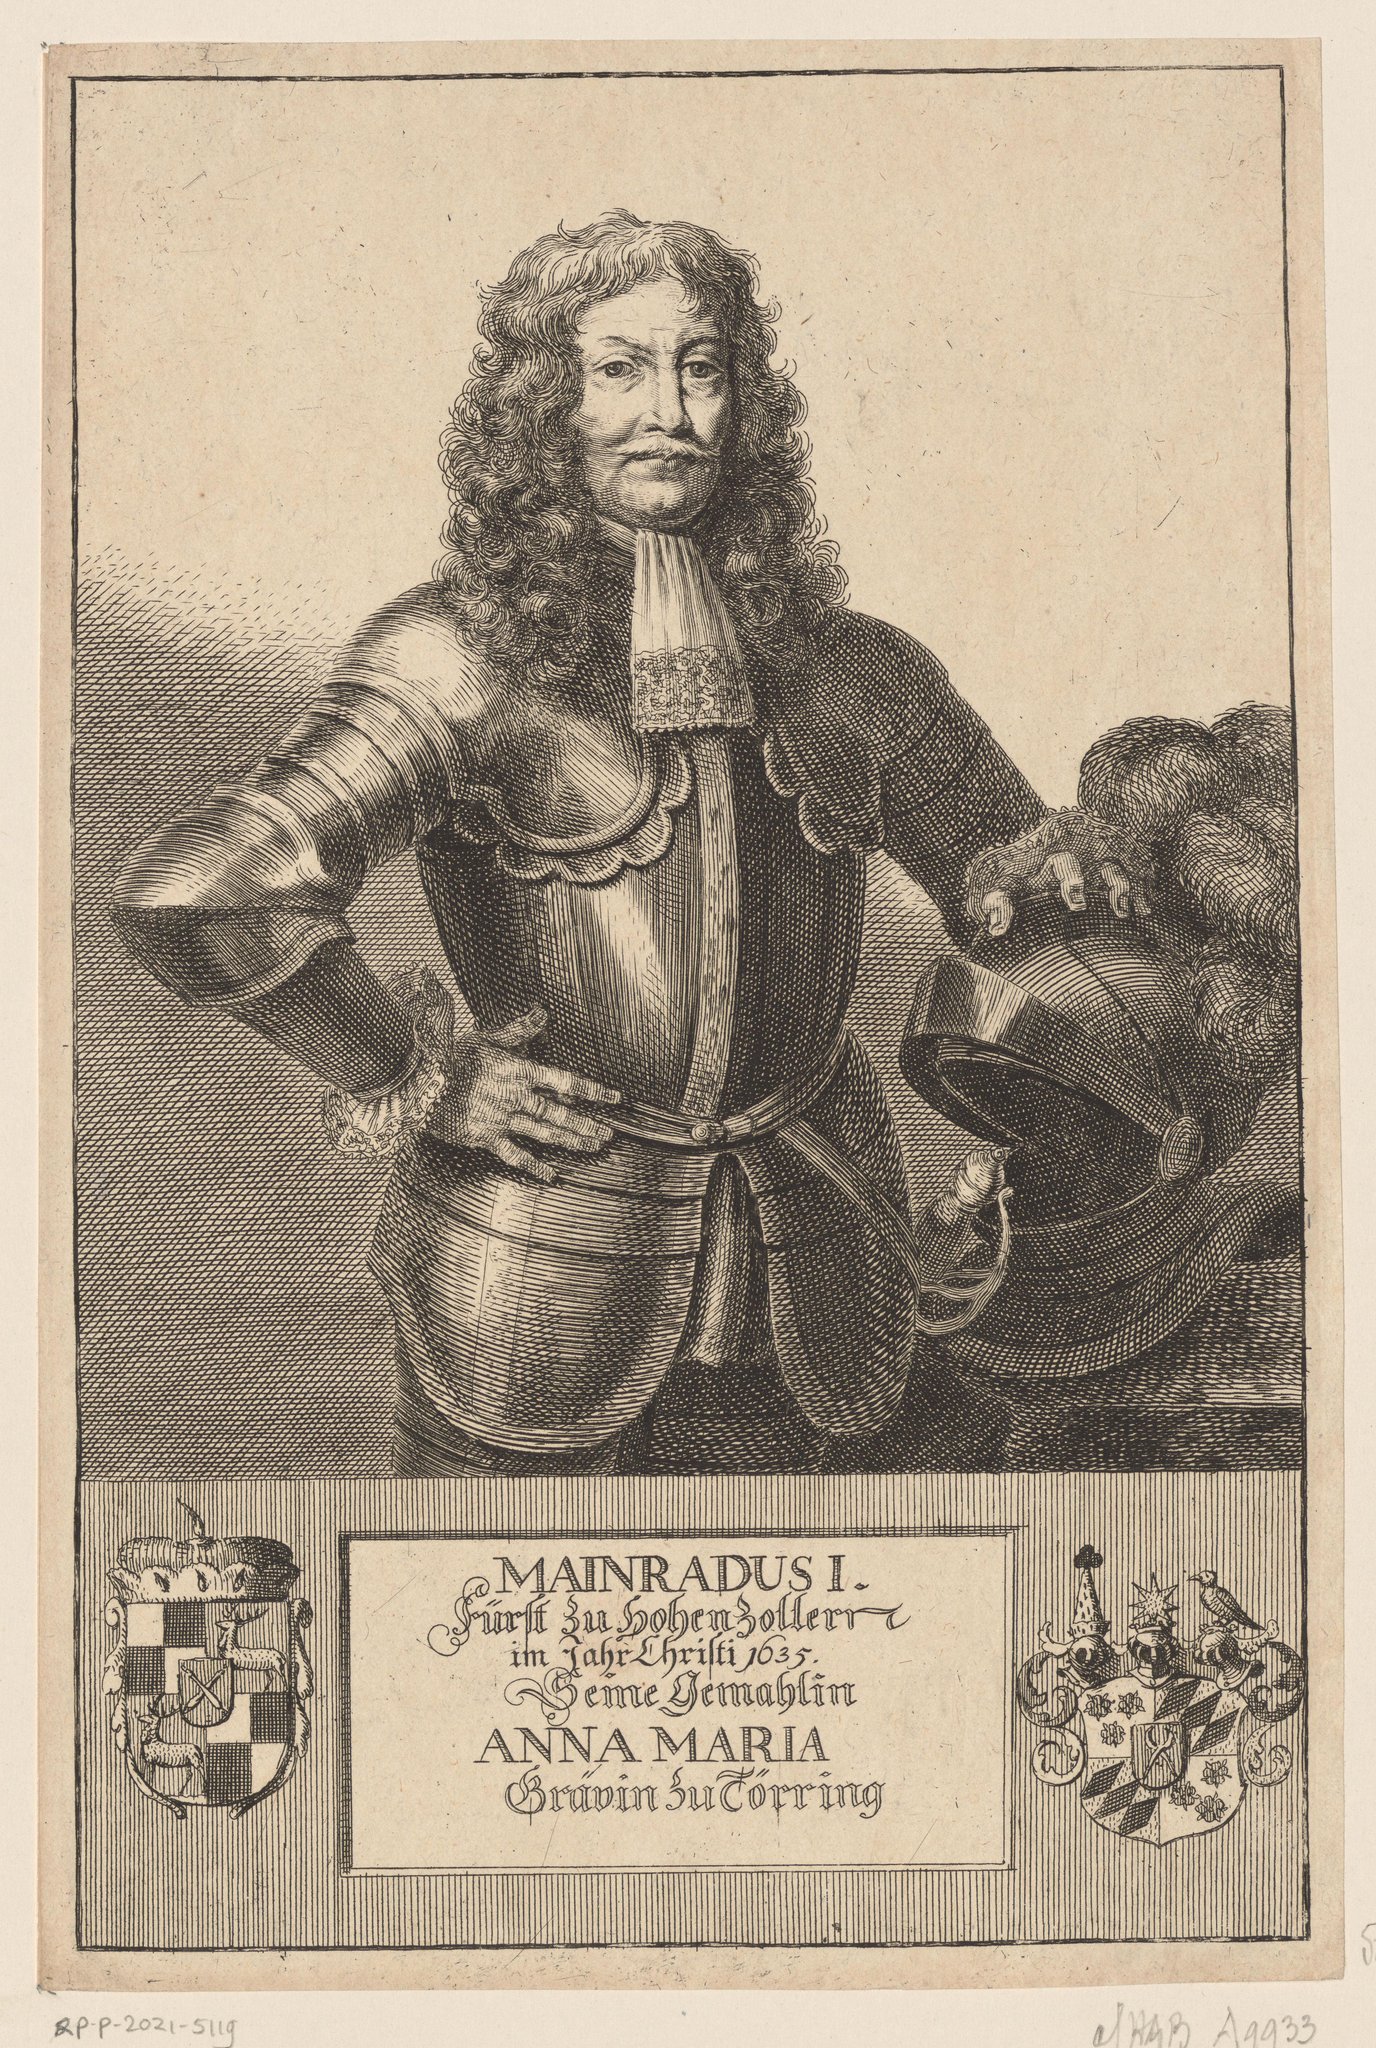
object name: book illustration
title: Portret van Meinrad I von Hohenzollern-Sigmaringen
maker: Anonymous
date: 1703-1714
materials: paper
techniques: engraving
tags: helmet, adult man, historical persons, armorial bearing, heraldry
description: Prent uit: Pregitzer, Johann Ulrich. Dess Heiligen Römischen Reichs Teutscher Nation, und dessen Stände, Regierungs- Und Ehren-Spiegel (...). Frankfurt en Leipzig: Friederich Roth-Scholtz, 1714. Of uit: Pregitzer, Johann Ulrich. Teutscher Regierungs- und Ehren-Spiegel, Vorbildend Des Teutschen Reichs, und desselben Stände, ersten Anfang, Fortleitung, Hoheit, Macht, Recht, und Freyheit (...). Berlijn: Rüdiger, 1703.